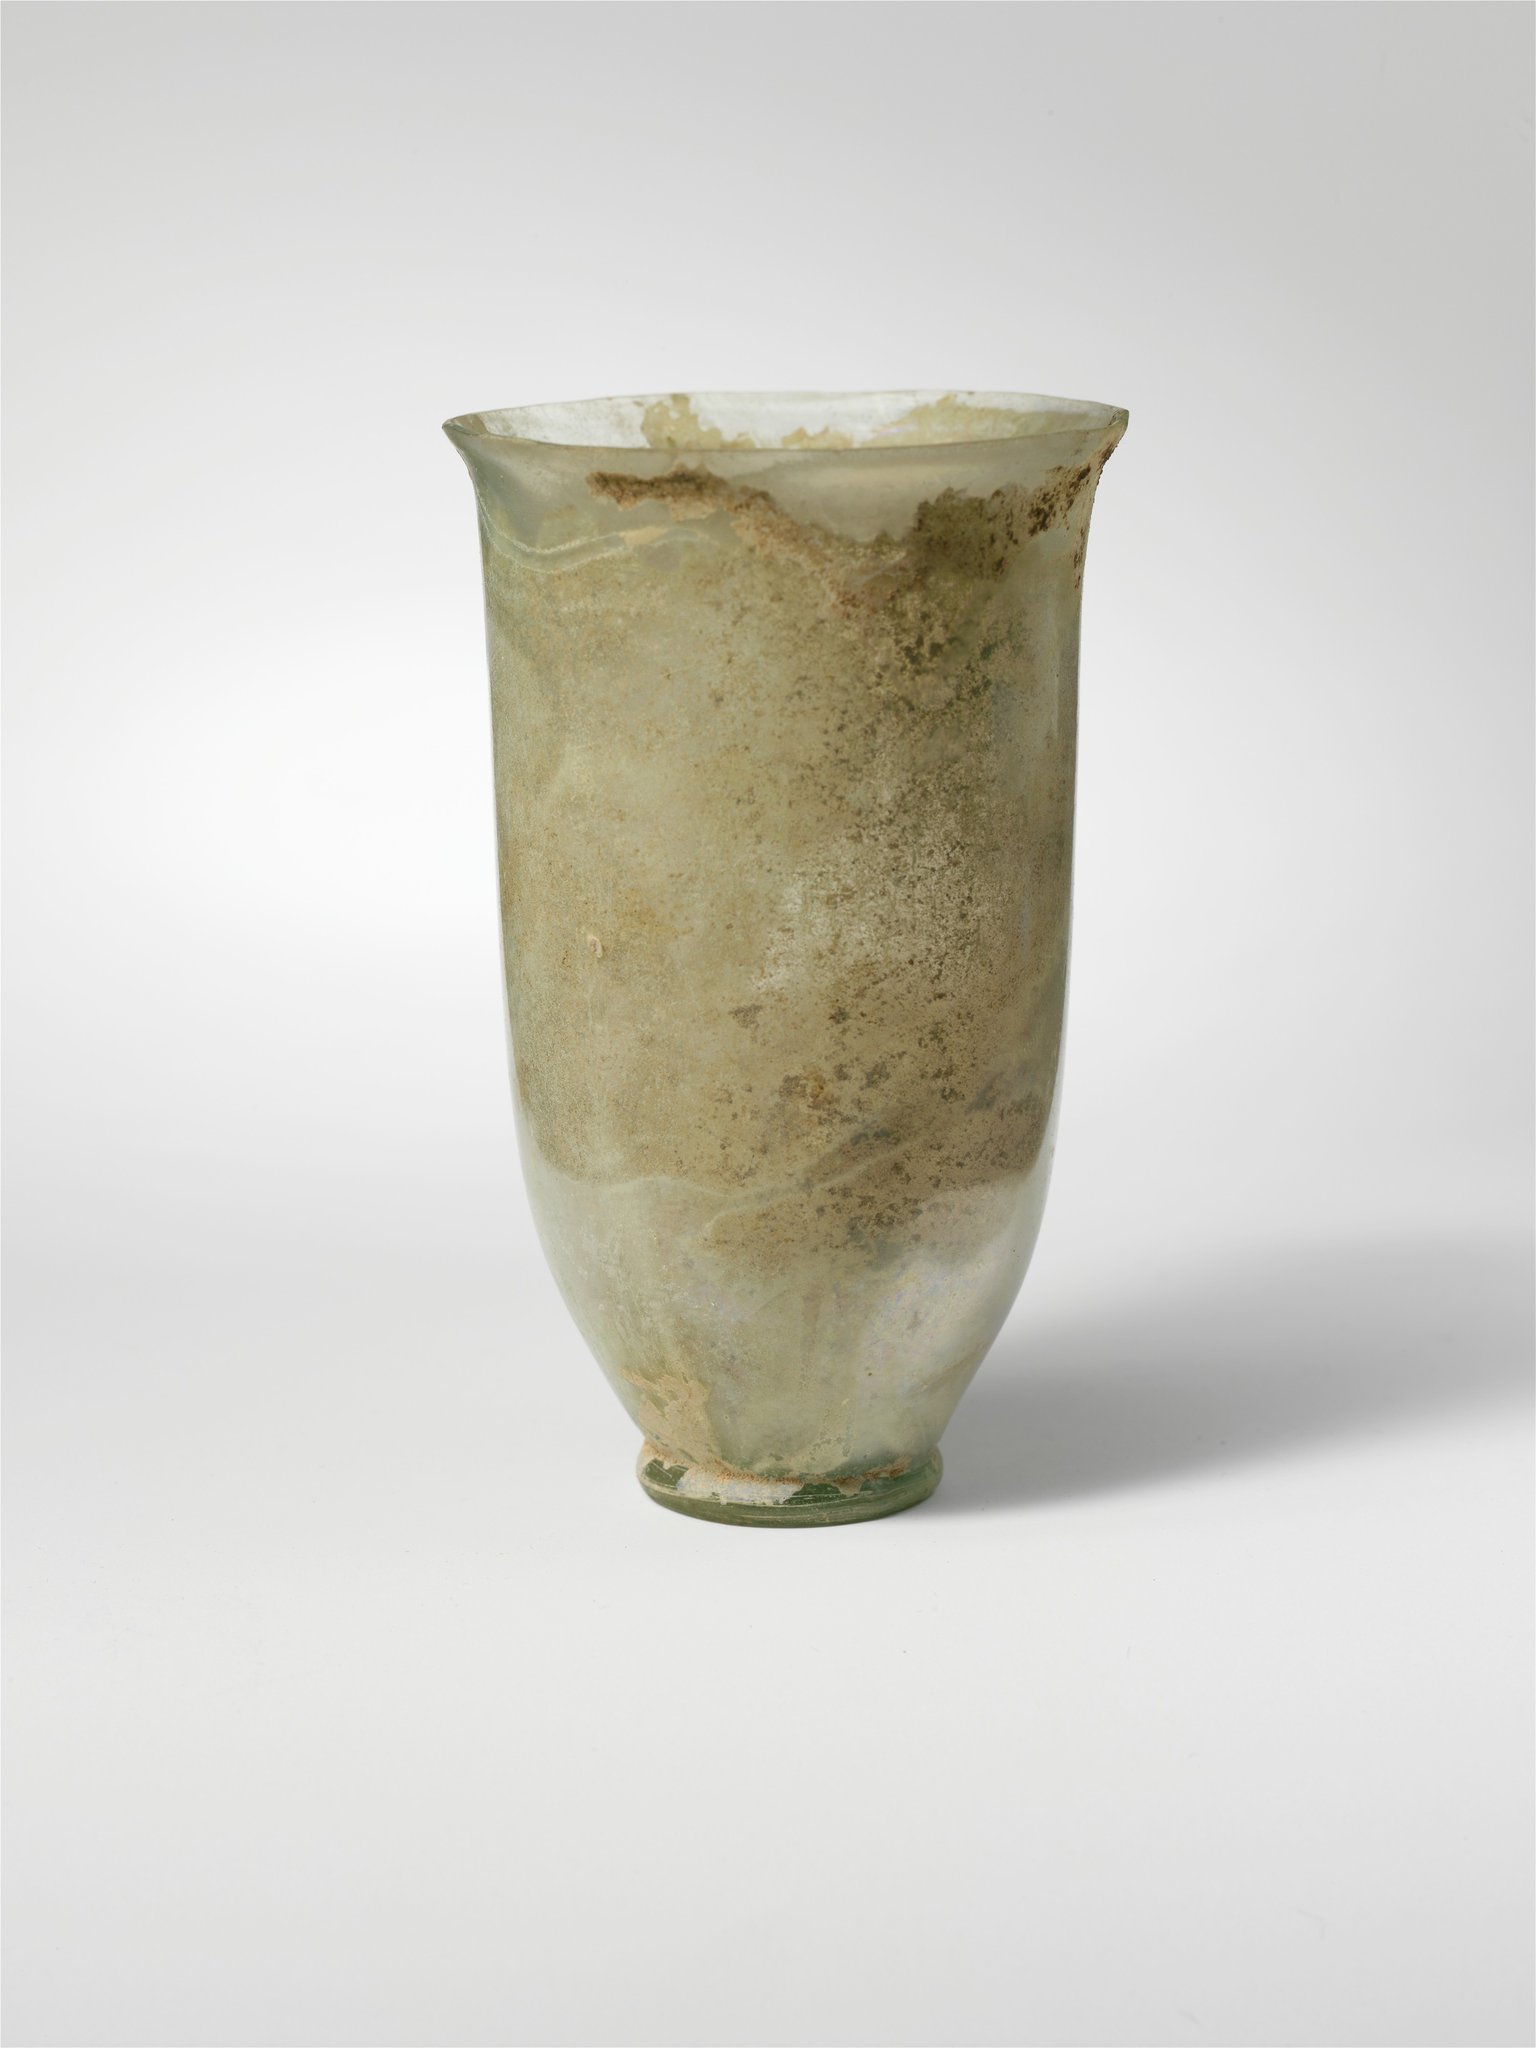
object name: beaker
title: Glass beaker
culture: roman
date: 1-100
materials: glass